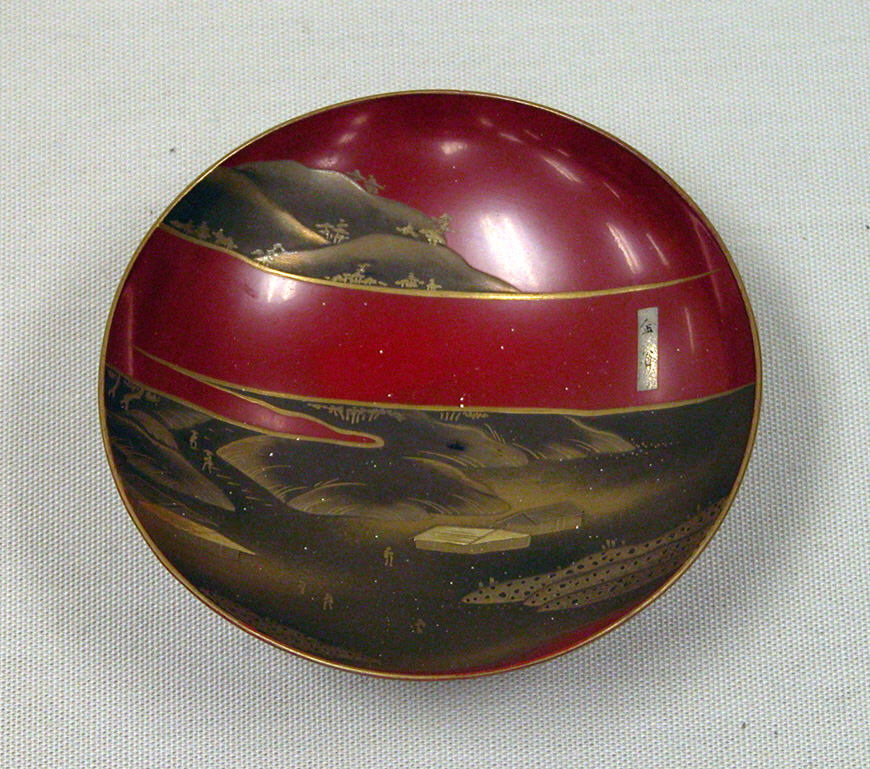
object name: wine cup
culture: japanese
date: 1834-1866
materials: gold, lacquer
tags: mountains